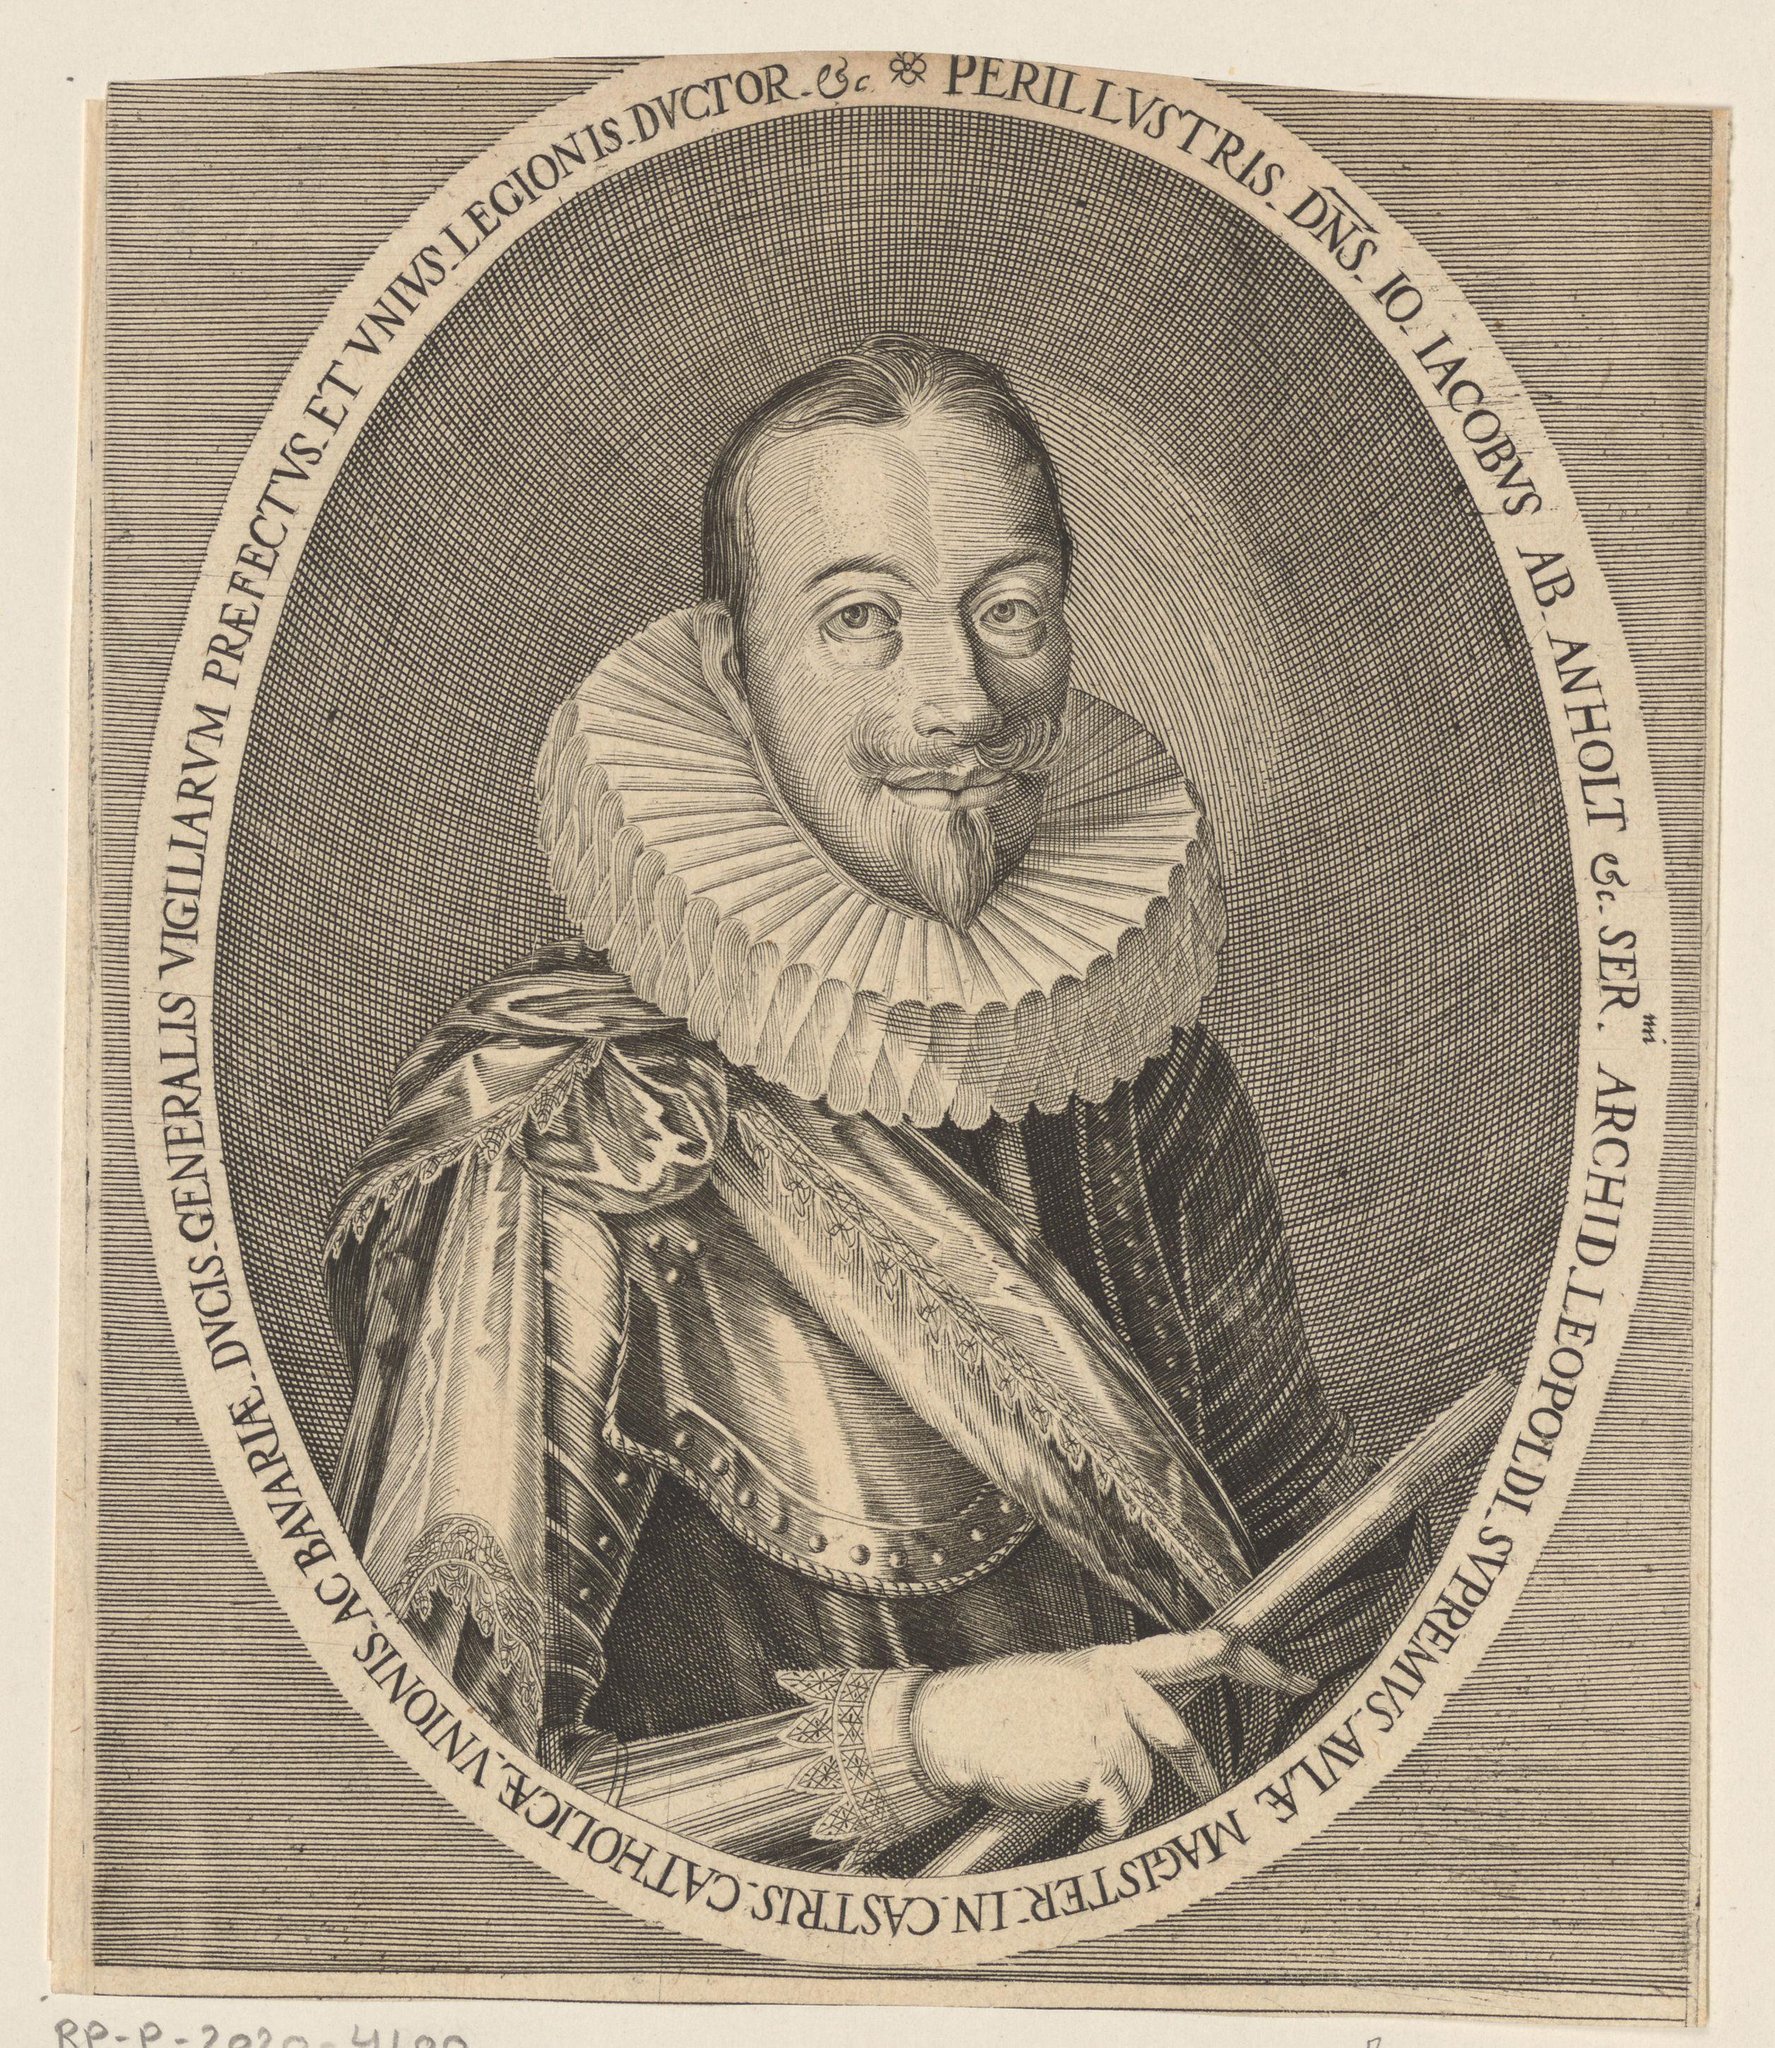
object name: print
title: Portret van Johan Jacob von Bronckhorst-Batenburg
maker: Anonymous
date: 1600-1649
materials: paper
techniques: engraving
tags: armour, historical persons, baton of general